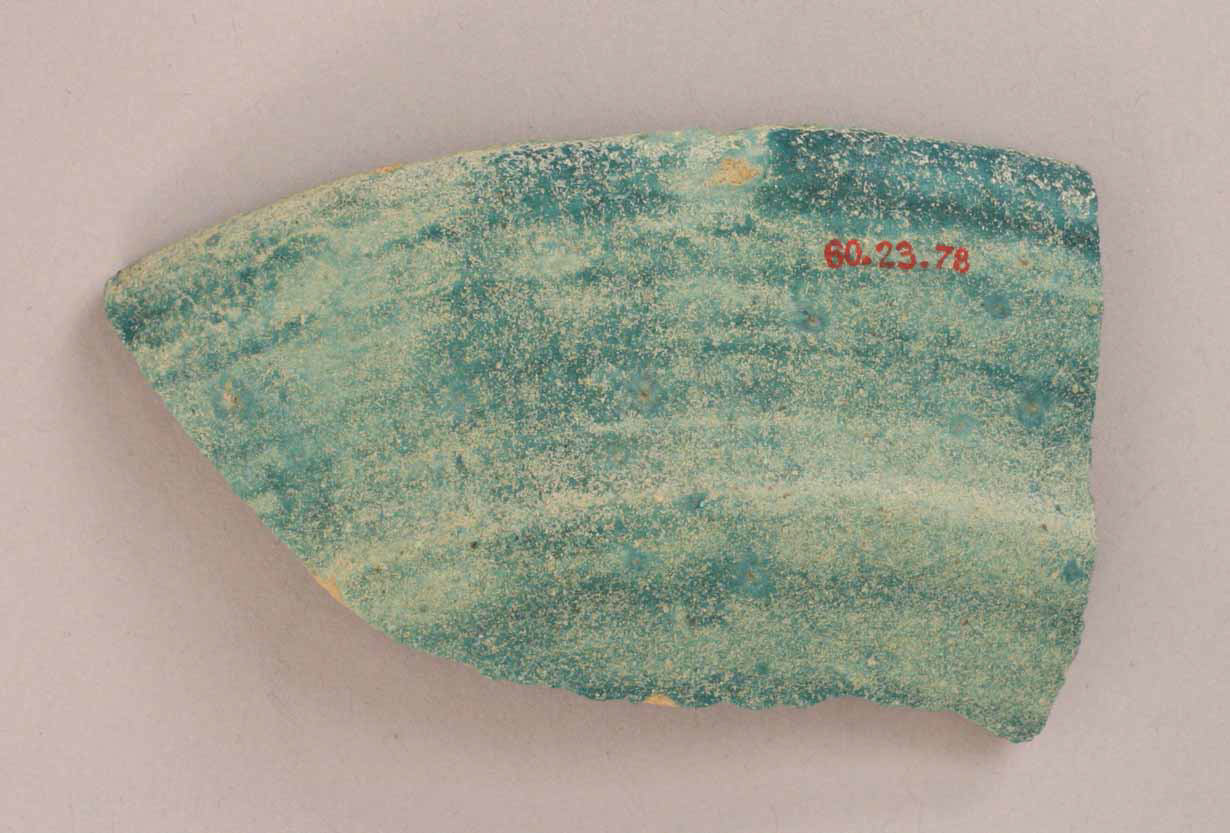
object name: fragment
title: Ceramic Fragment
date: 701-900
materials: earthenware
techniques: glazing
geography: saudi arabia